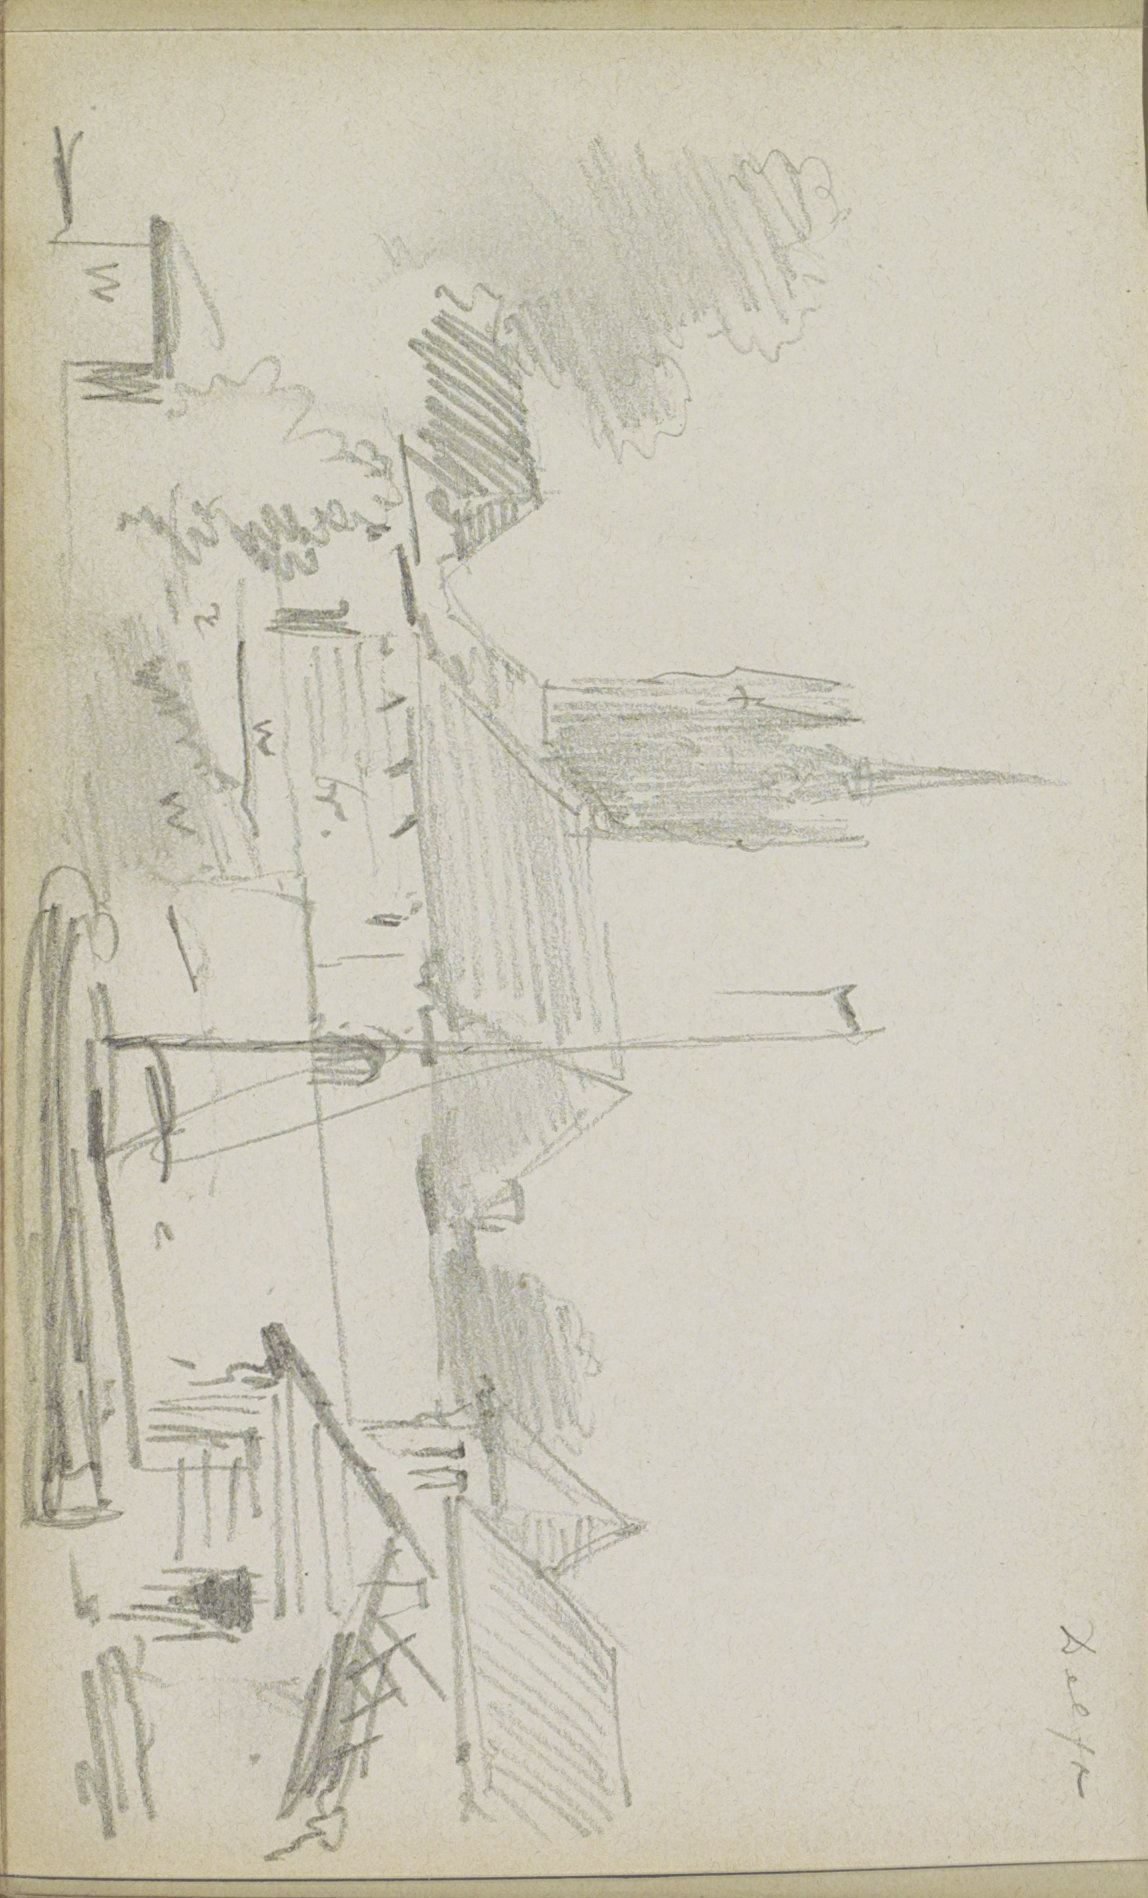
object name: sketchbook leaf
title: Gezicht op Delft met de Oude Kerk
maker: adrianus eversen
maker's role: draughtsman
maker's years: 1818-1897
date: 1828-1897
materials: paper, pencil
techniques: stumping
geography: delft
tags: city-view, and landscape with man-made constructions, sailing-ship, sailing-boat, church (exterior)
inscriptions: annotation: ‘Delft’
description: Gezicht op Delft met de Oude Kerk. Vooraan een zeilschip. Blad 64 verso uit een schetsboek met 69 bladen vervaardigd in de omgeving van Delft, Rotterdam, Oudewater en Harlingen.